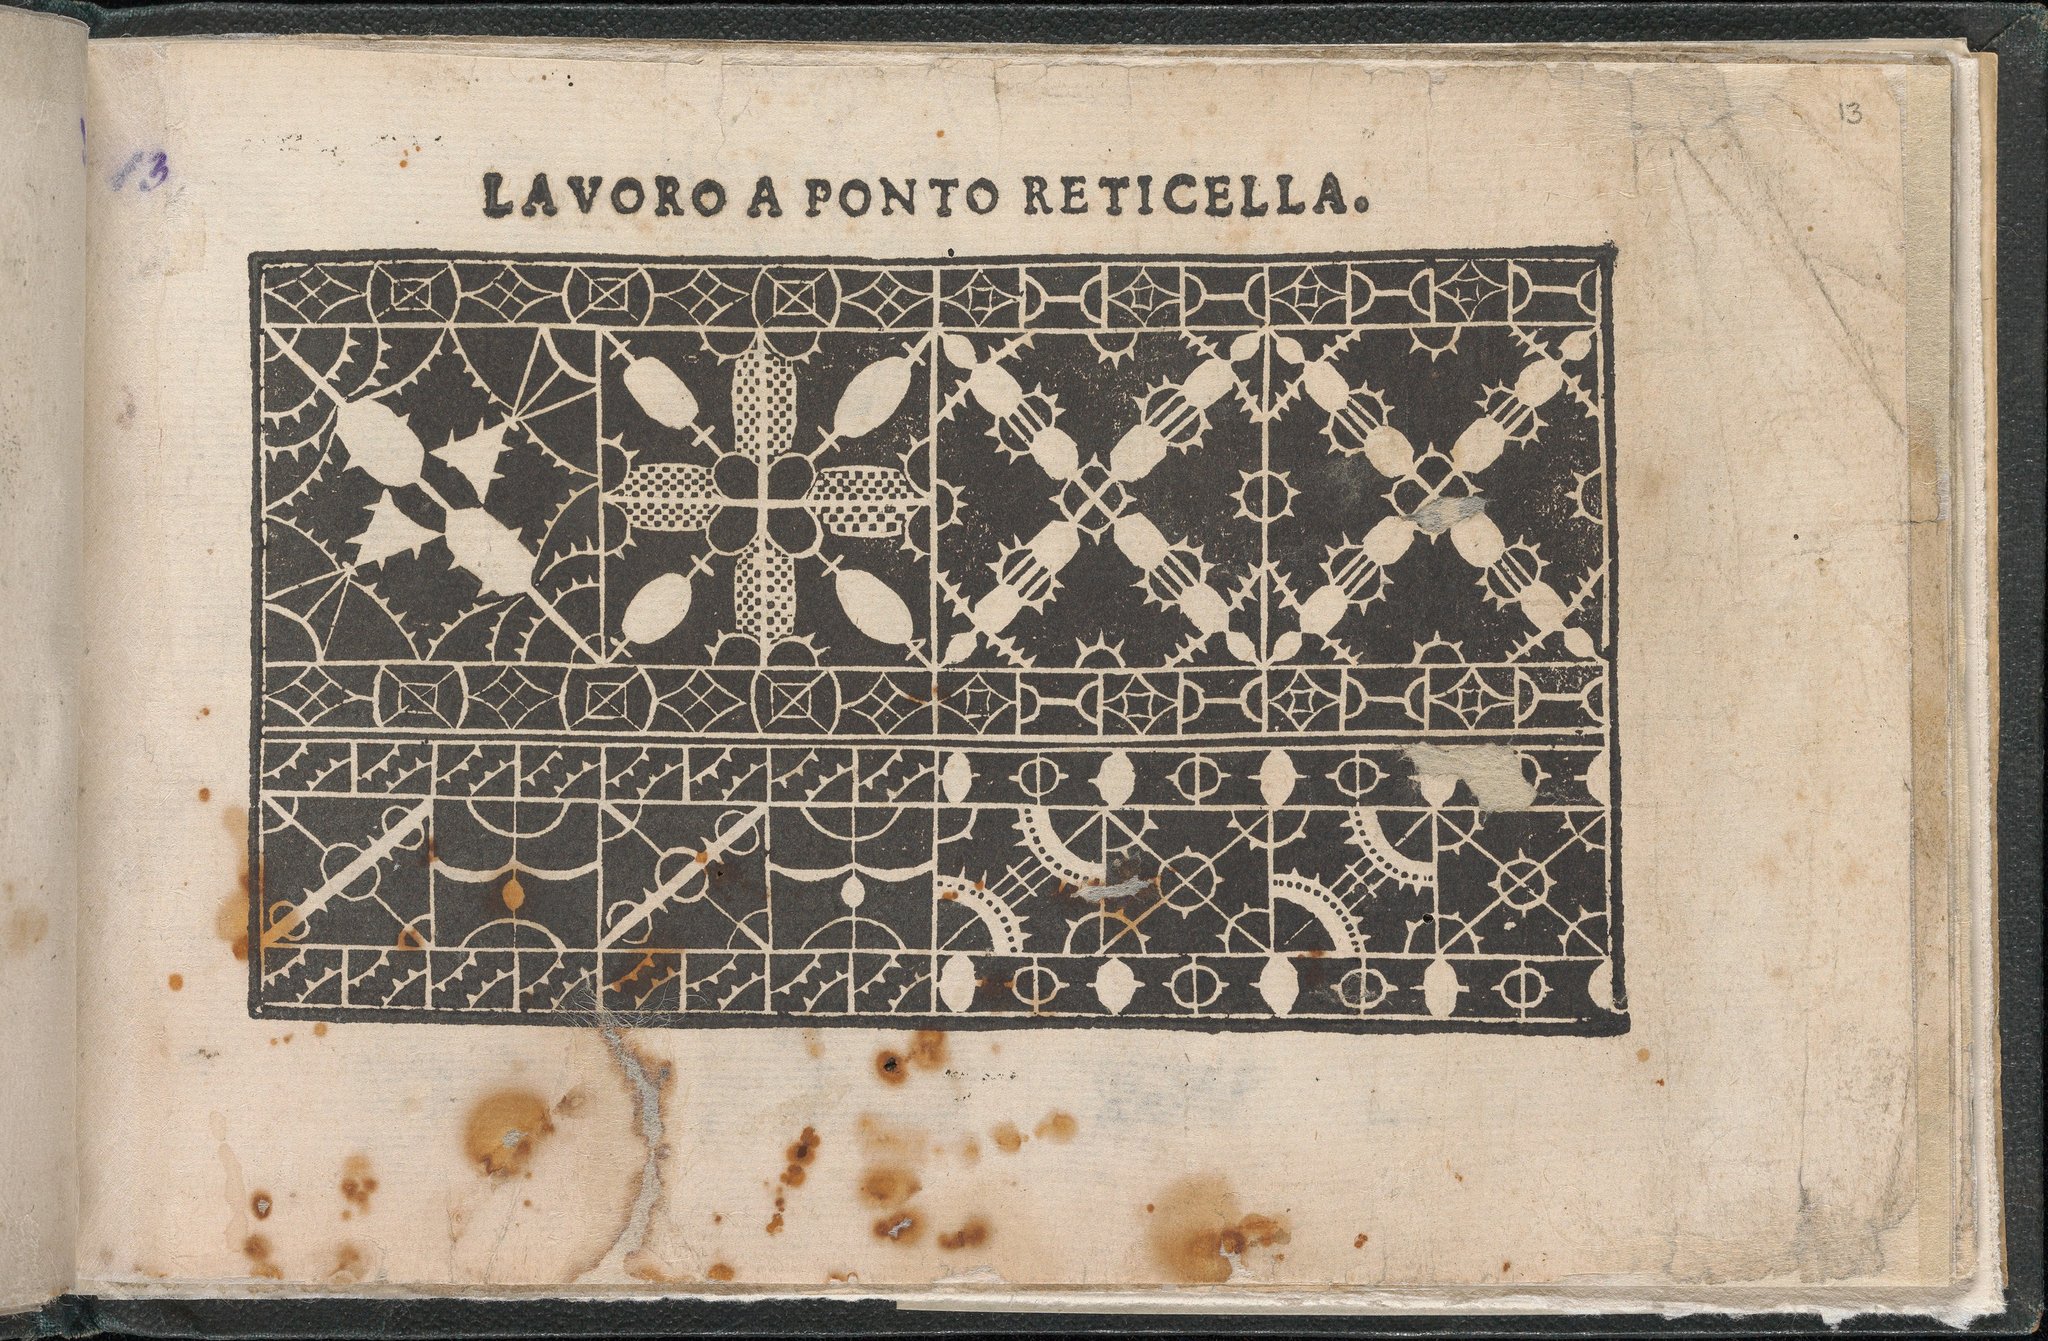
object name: book print ornament architecture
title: Gemma pretiosa della virtuose donne, page 13 (recto)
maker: isabella catanea parasole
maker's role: designer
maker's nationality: italian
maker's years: 1565-1625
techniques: woodcut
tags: ornament